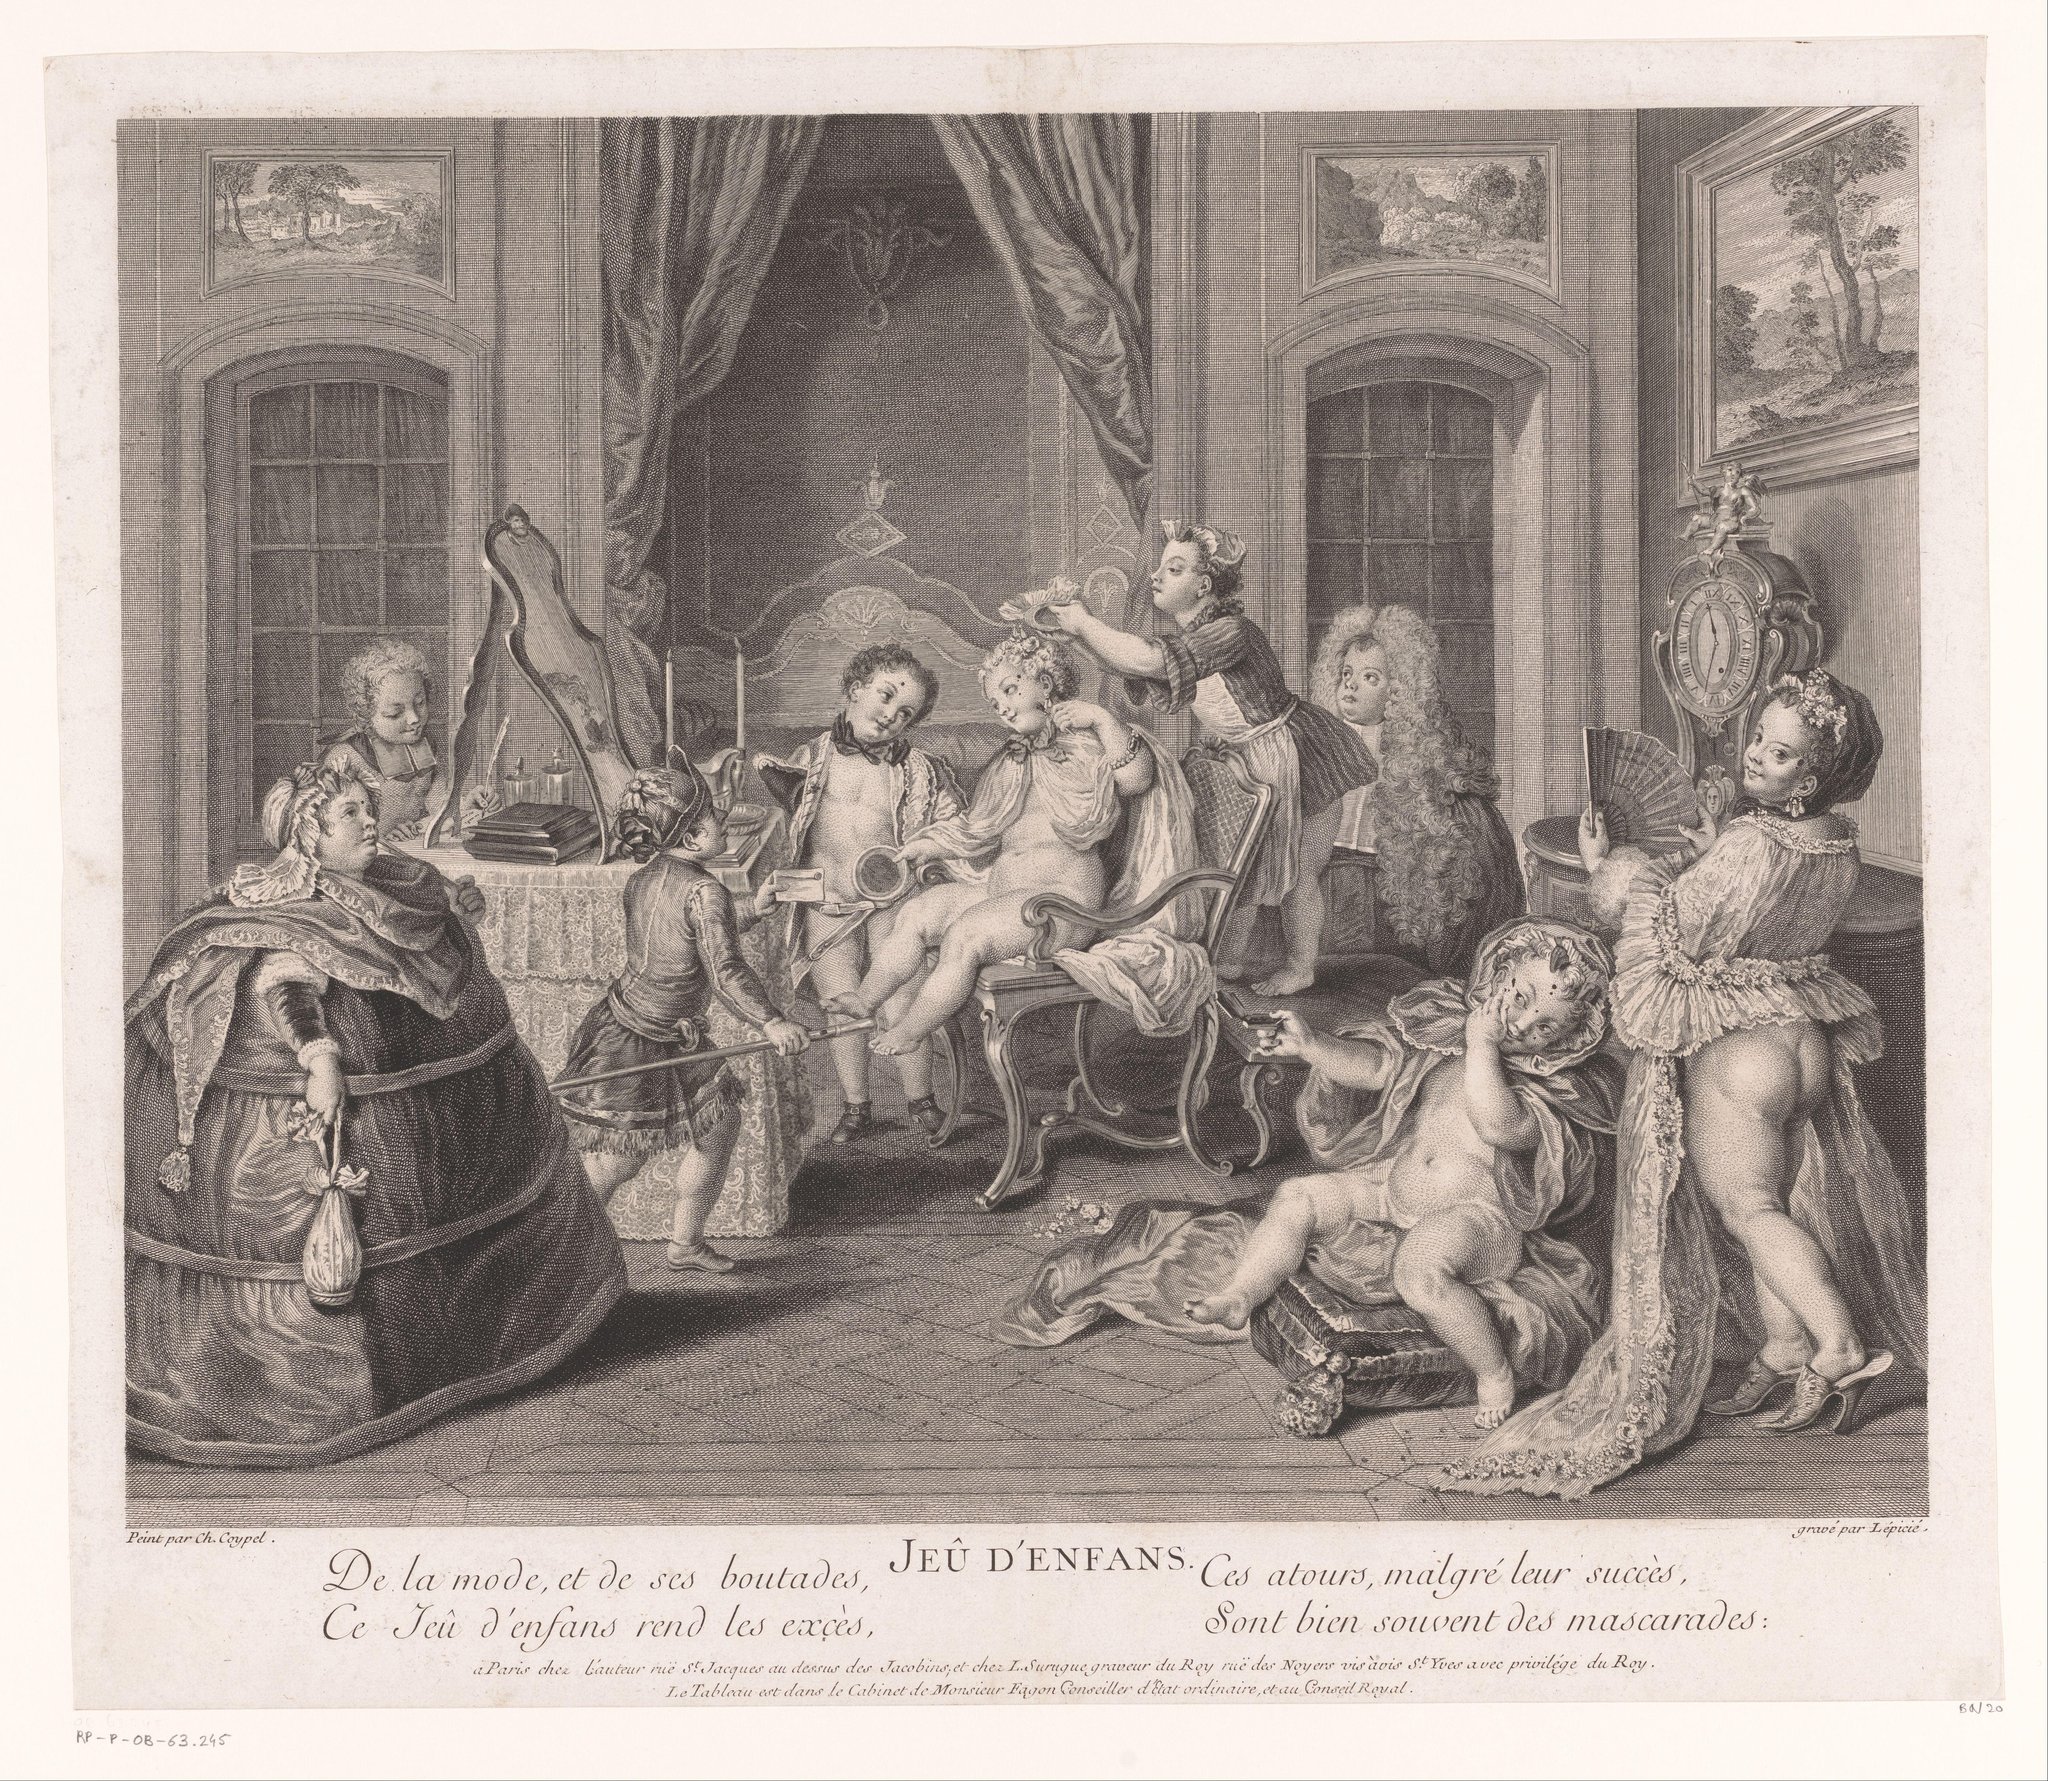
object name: print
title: Kinderen spelen volwassenen aan hun toilet na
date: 1731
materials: paper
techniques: engraving, etching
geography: france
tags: making toilet, trade games, imitative games, imitating adults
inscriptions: collector's mark: Lugt 240